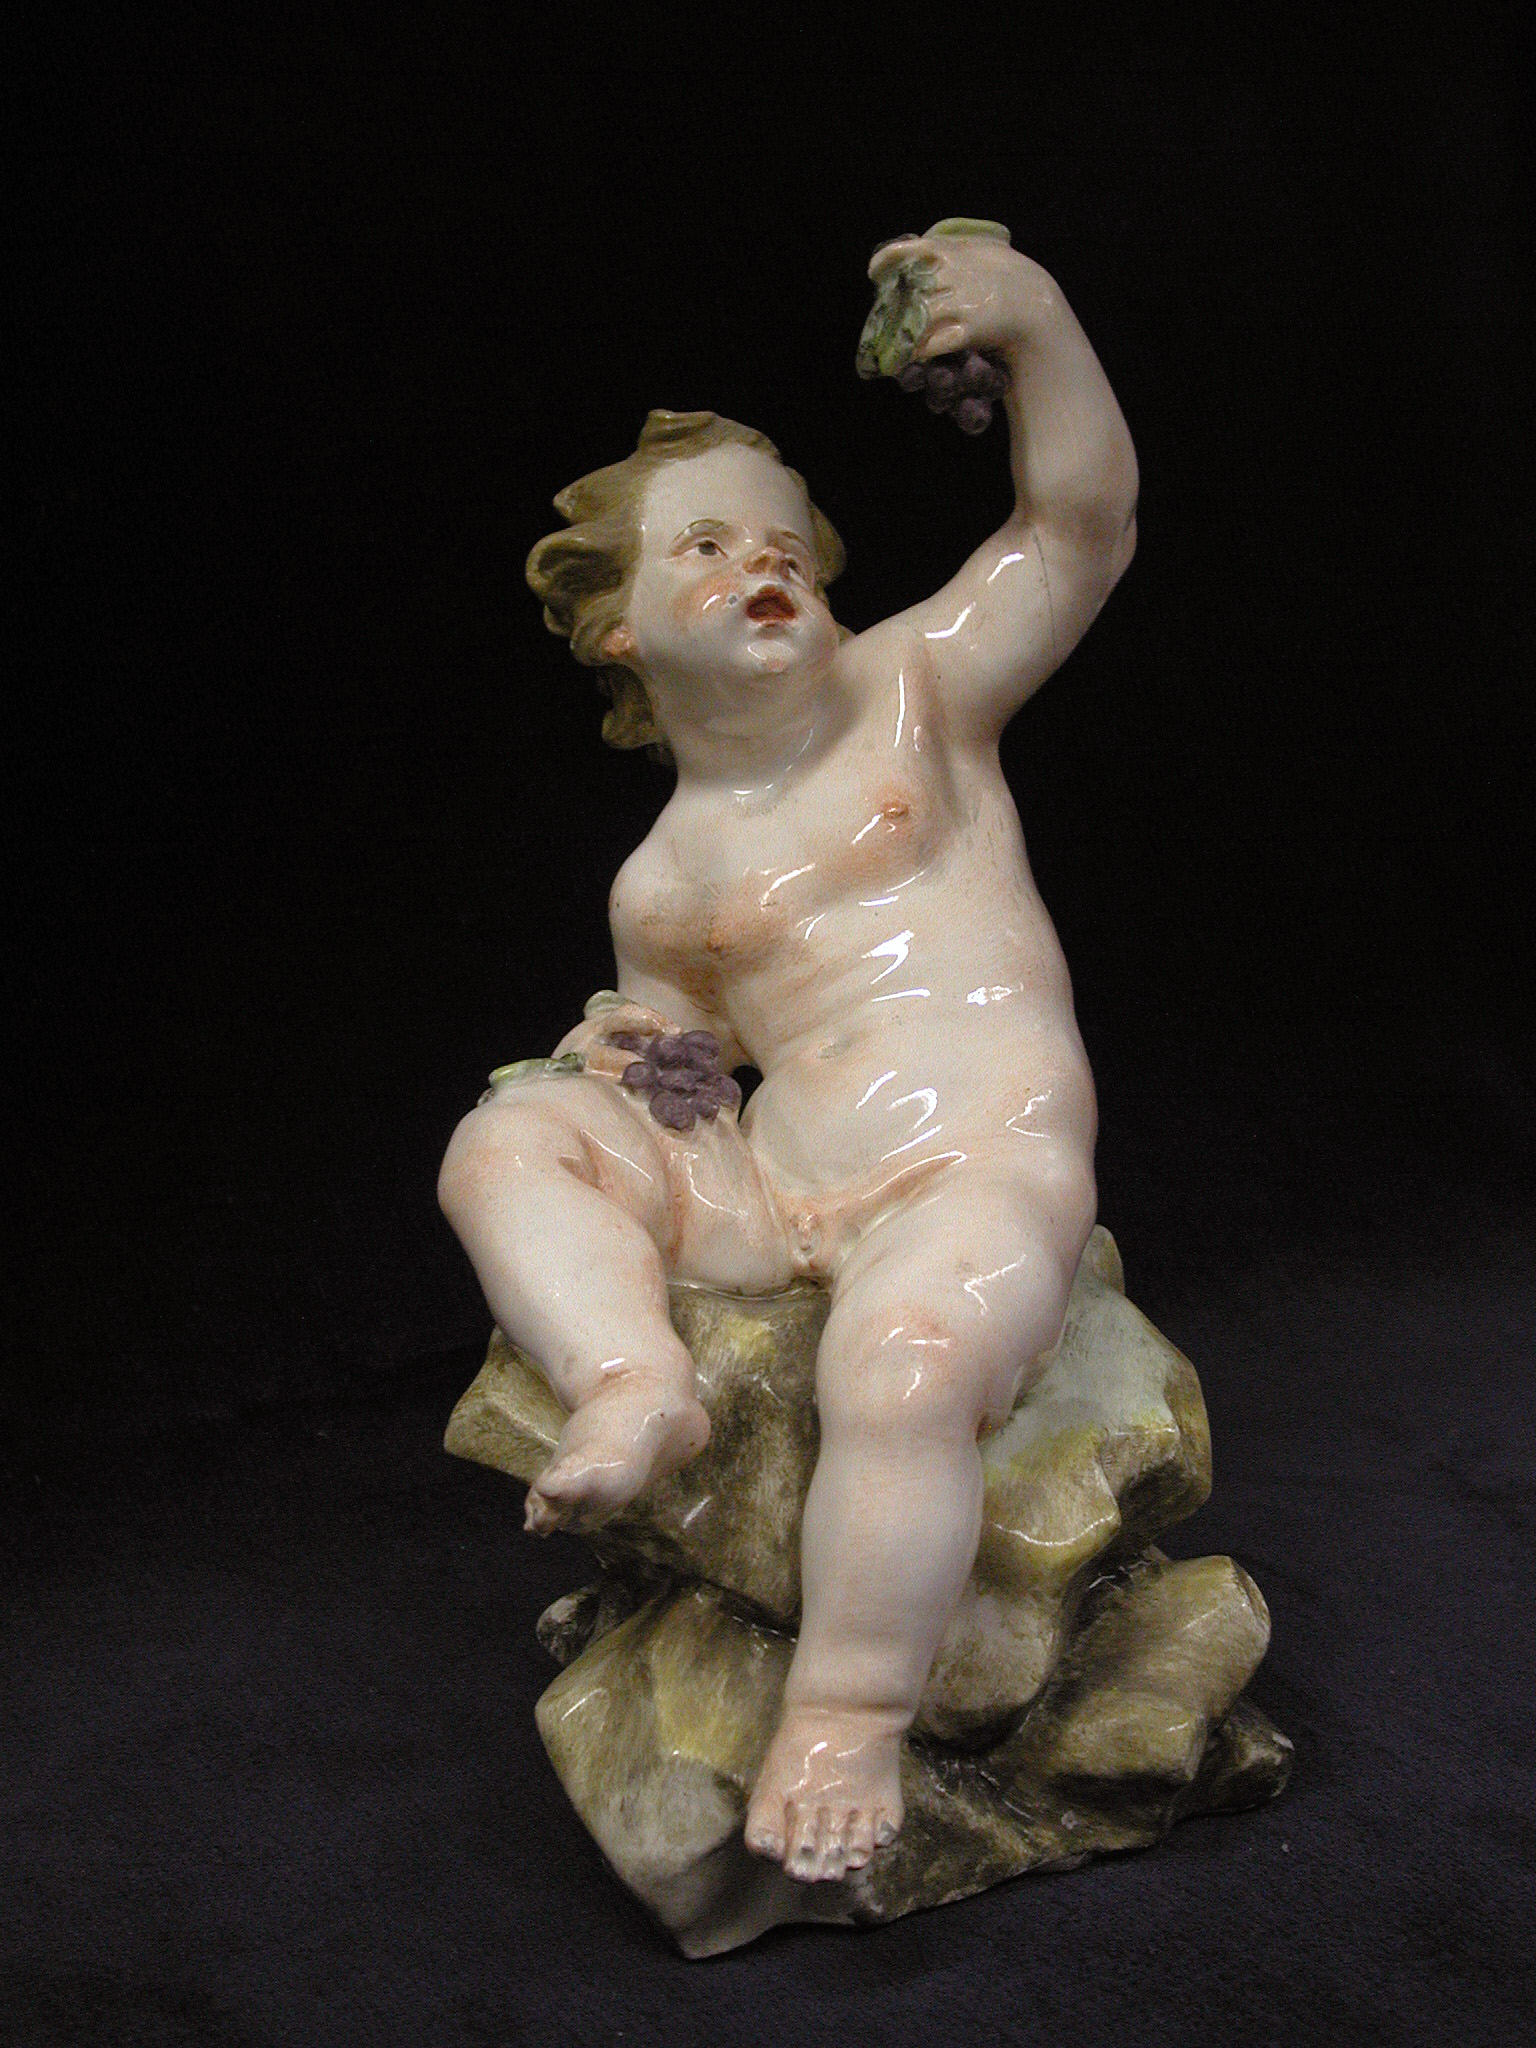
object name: figure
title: Child with Grapes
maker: real fabrica de buen retiro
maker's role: factory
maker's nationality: spanish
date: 1770-1780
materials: soft paste porcelain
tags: grapes,children